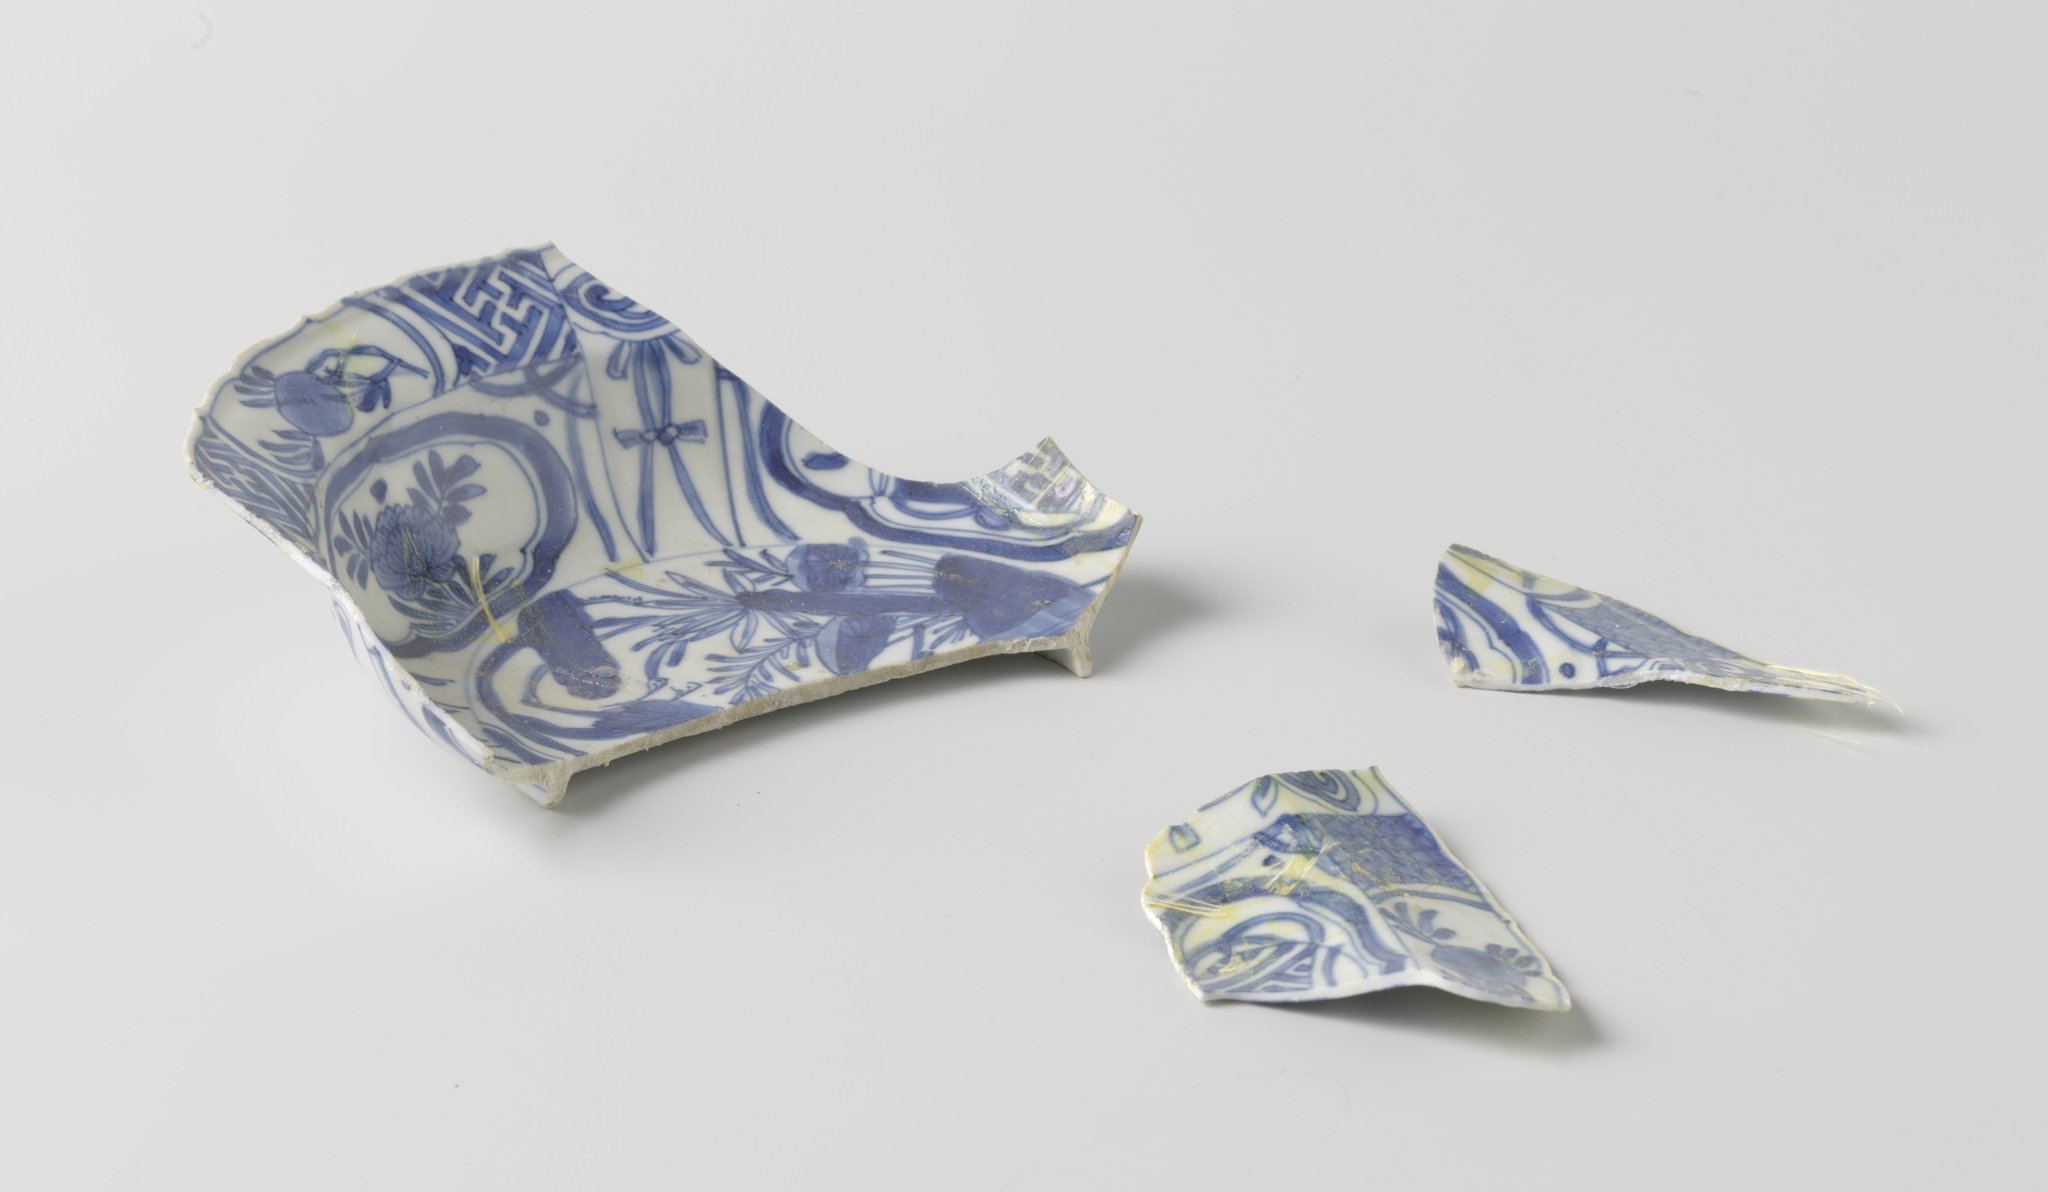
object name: deep dish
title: Scherven van diep bord uit V.O.C.-schip de 'Witte Leeuw'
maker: Anonymous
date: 1613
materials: bone china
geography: jingdezhen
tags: verenigde oostindische compagnie, sint-helena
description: A bowl with a flattened rim. Cartouches with fruits enclosed by diaper patterns. A central decoration of birds and a lotus. Panels decorated with peaches and symbols.